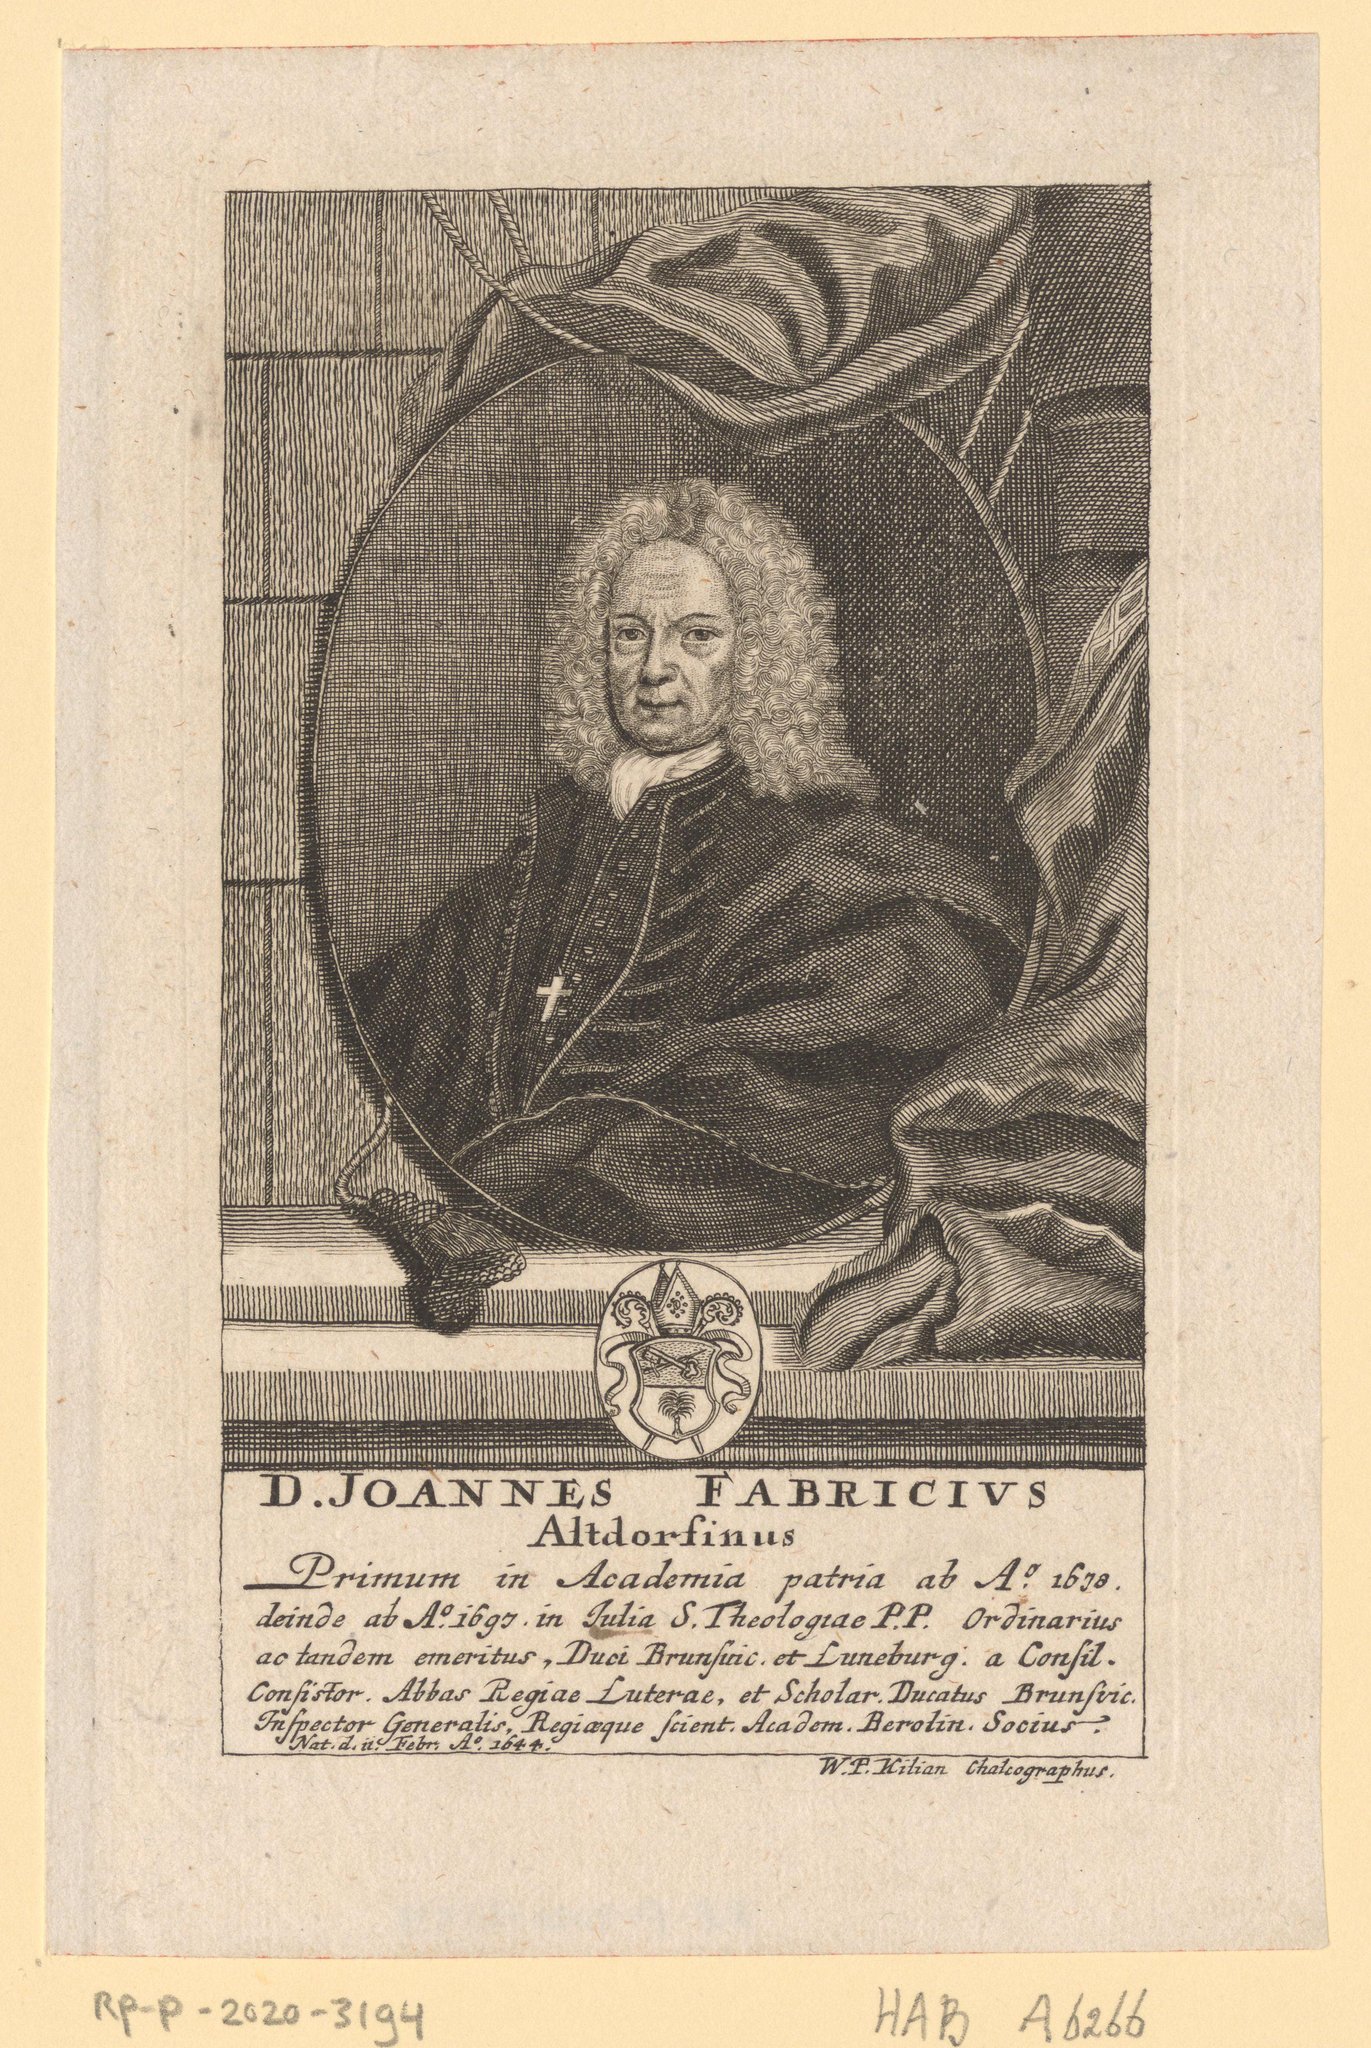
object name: print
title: Portret van Johann Fabricius IV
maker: wolfgang philipp kilian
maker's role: artist, draughtsman, print maker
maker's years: 1654-1732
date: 1722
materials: paper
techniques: engraving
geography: germany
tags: theologian, (feigned) picture curtain, historical persons, armorial bearing, heraldry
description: Prent waarschijnlijk uit: Zeltner, Gustav Georg. Vitae Theologorum Altorphinorum (...). Neurenberg & Altdorf: erven Johann Daniel Tauber, 1722.